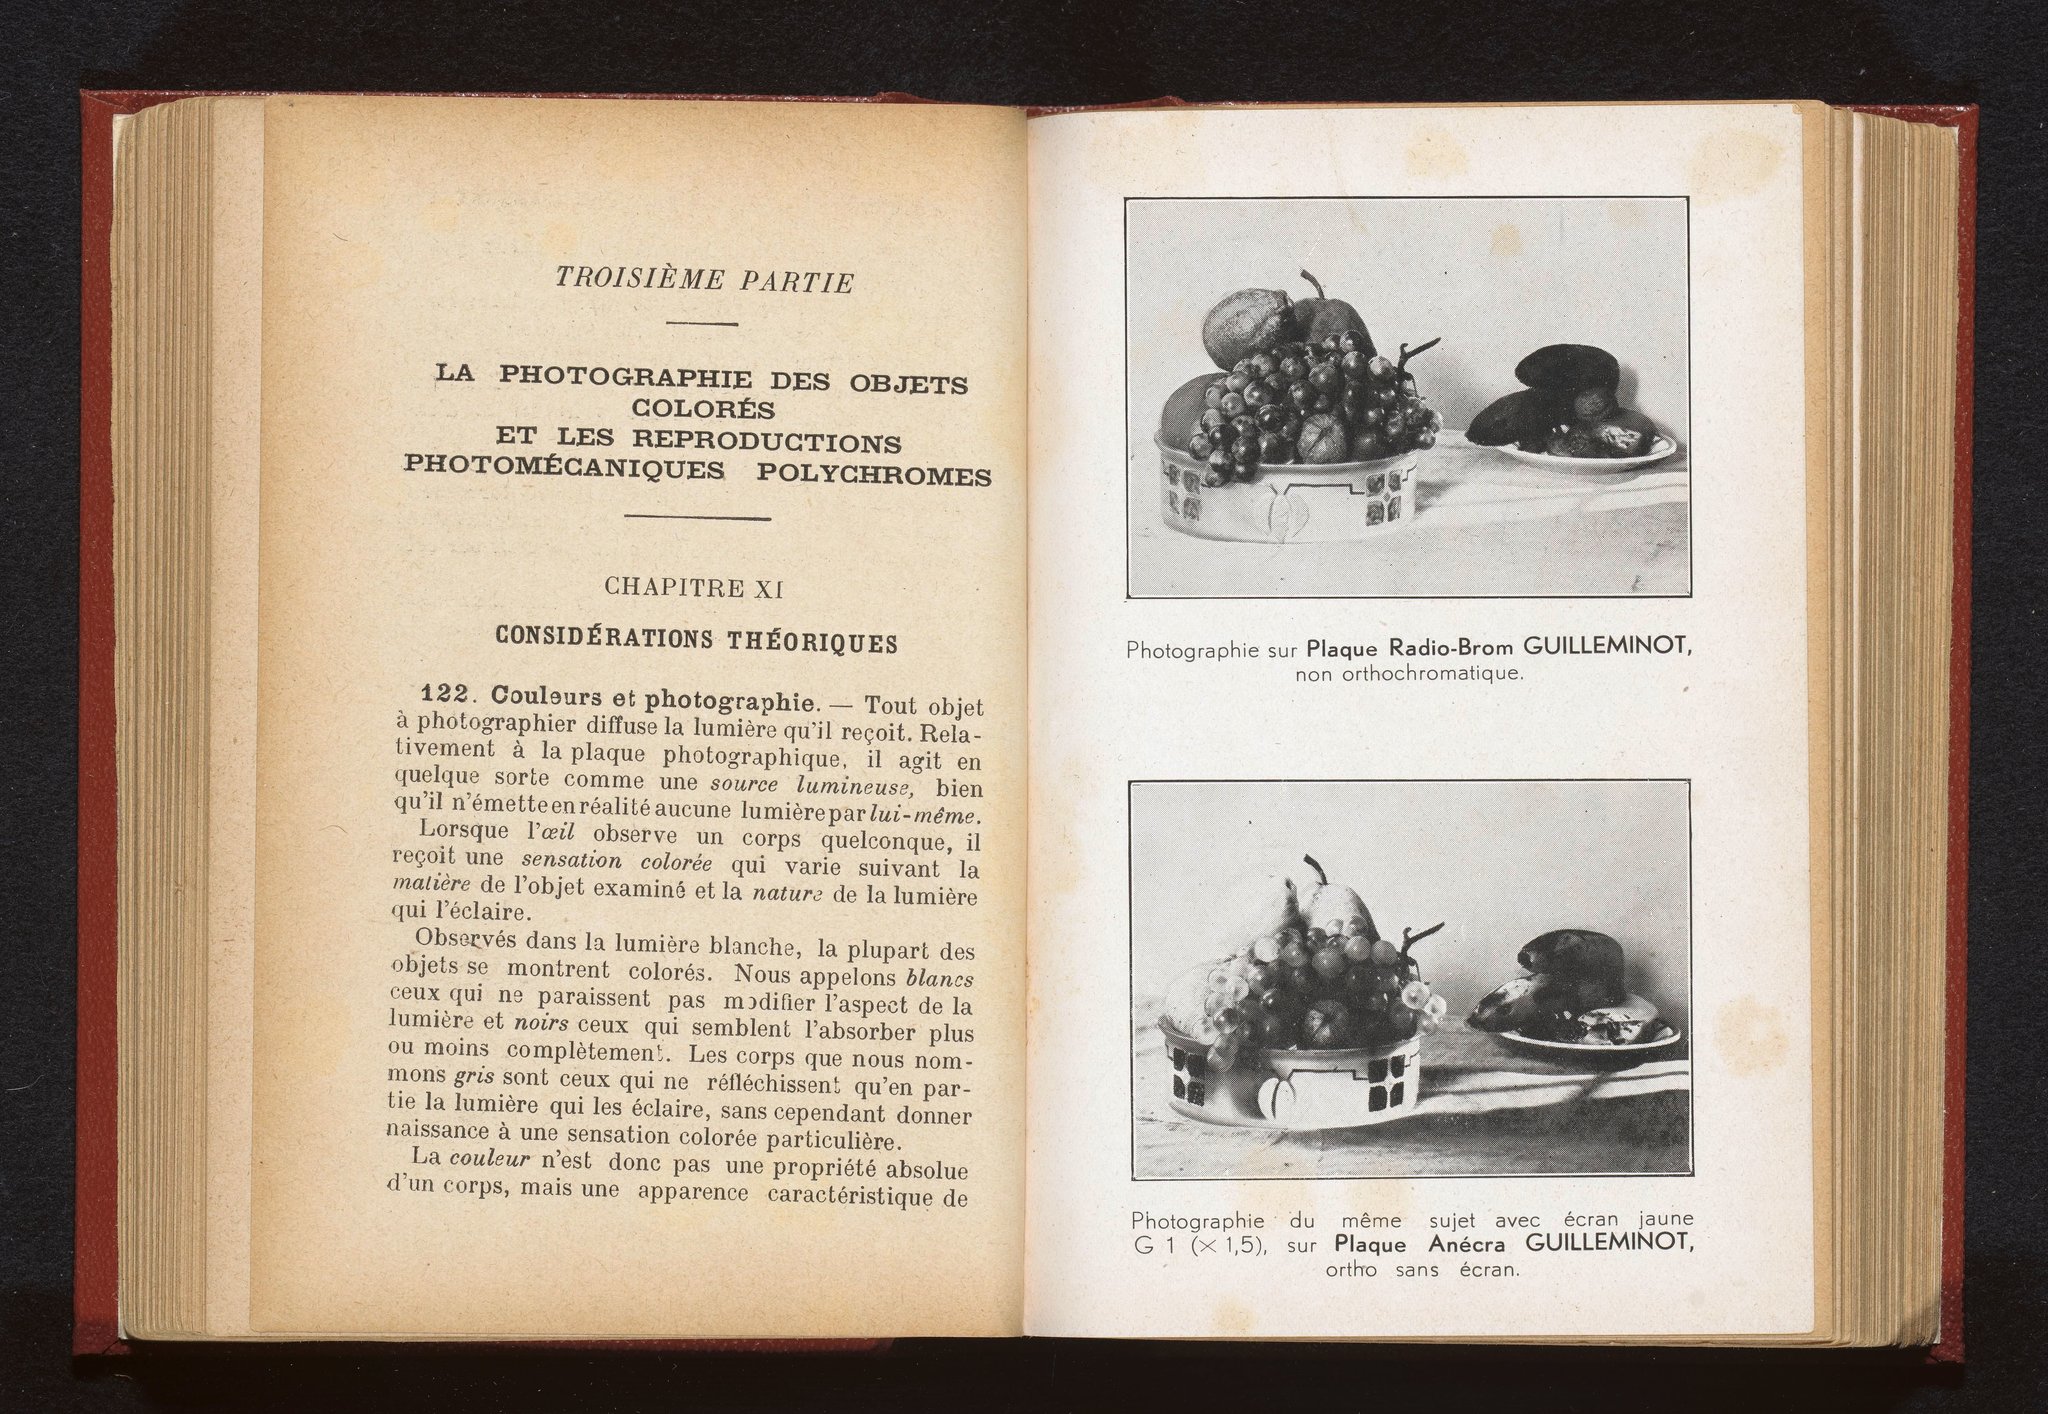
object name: page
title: Twee stillevens met fruit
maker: Anonymous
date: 1922-1932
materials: paper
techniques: autotype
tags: foodstuffs; still life of foodstuffs